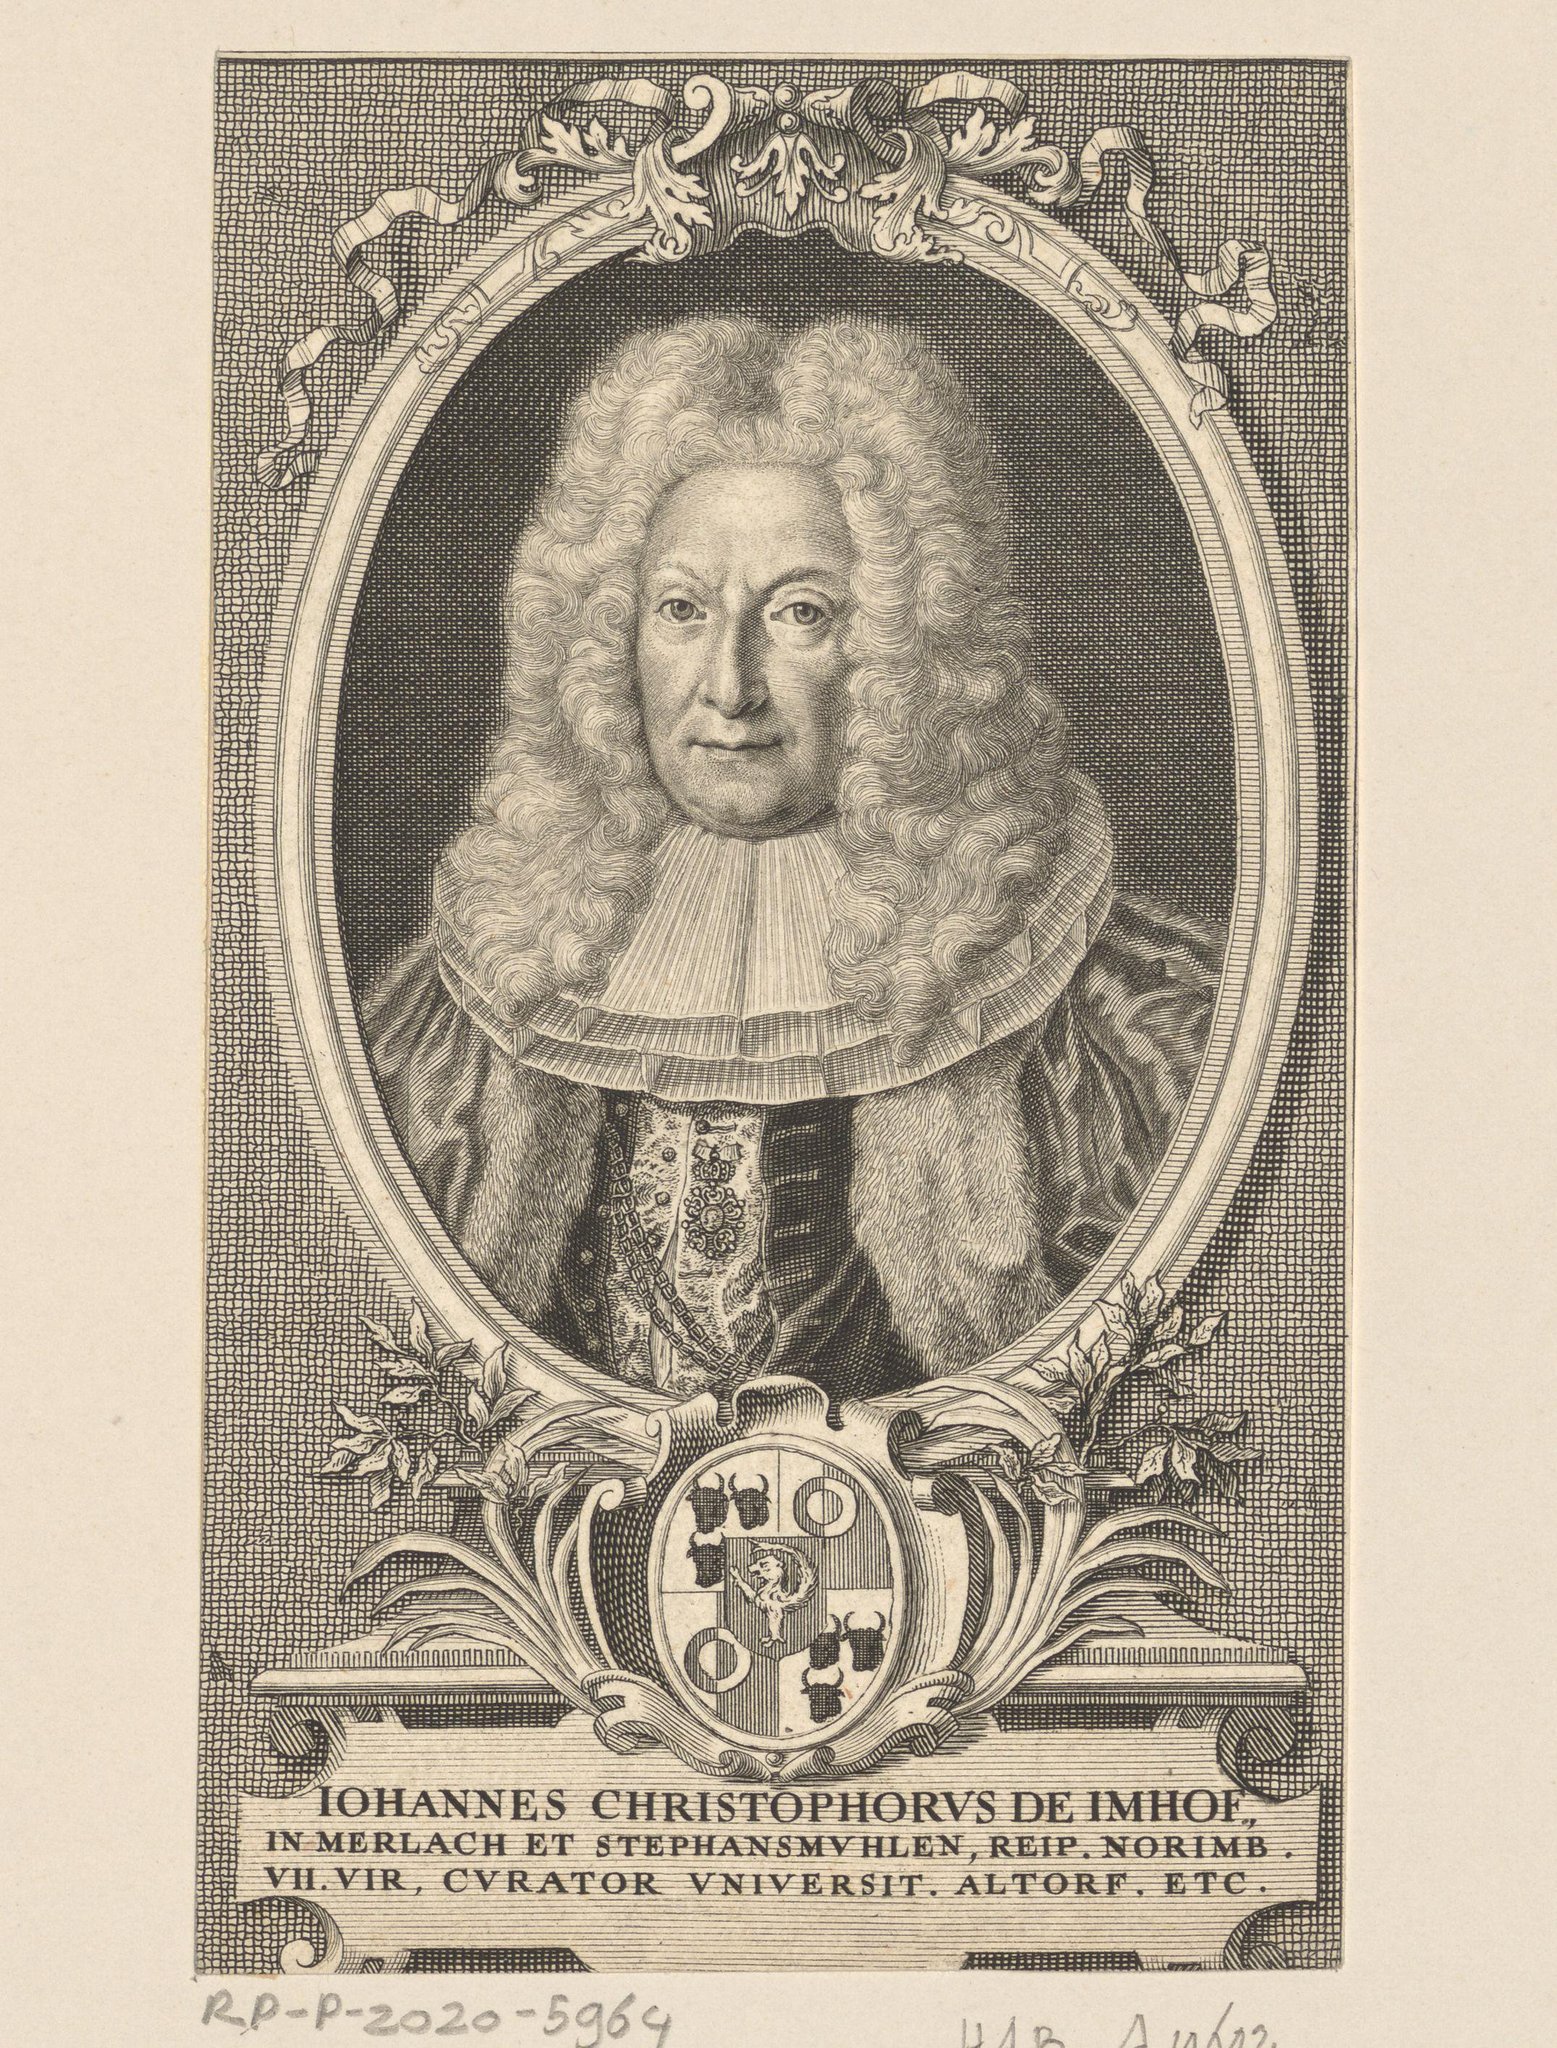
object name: print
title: Portret van Johann Christoph Imhof I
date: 1723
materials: paper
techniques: engraving, etching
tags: mayor, mayor, burgomaster, historical persons, armorial bearing, heraldry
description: Prent maakt deel uit van een grotere prent met vier portretten die later is verknipt. Prent mogelijk uit: Acta sacrorum saecularium, quae (...). S.l.: Jobst Wilhelm Kohles, 1723.